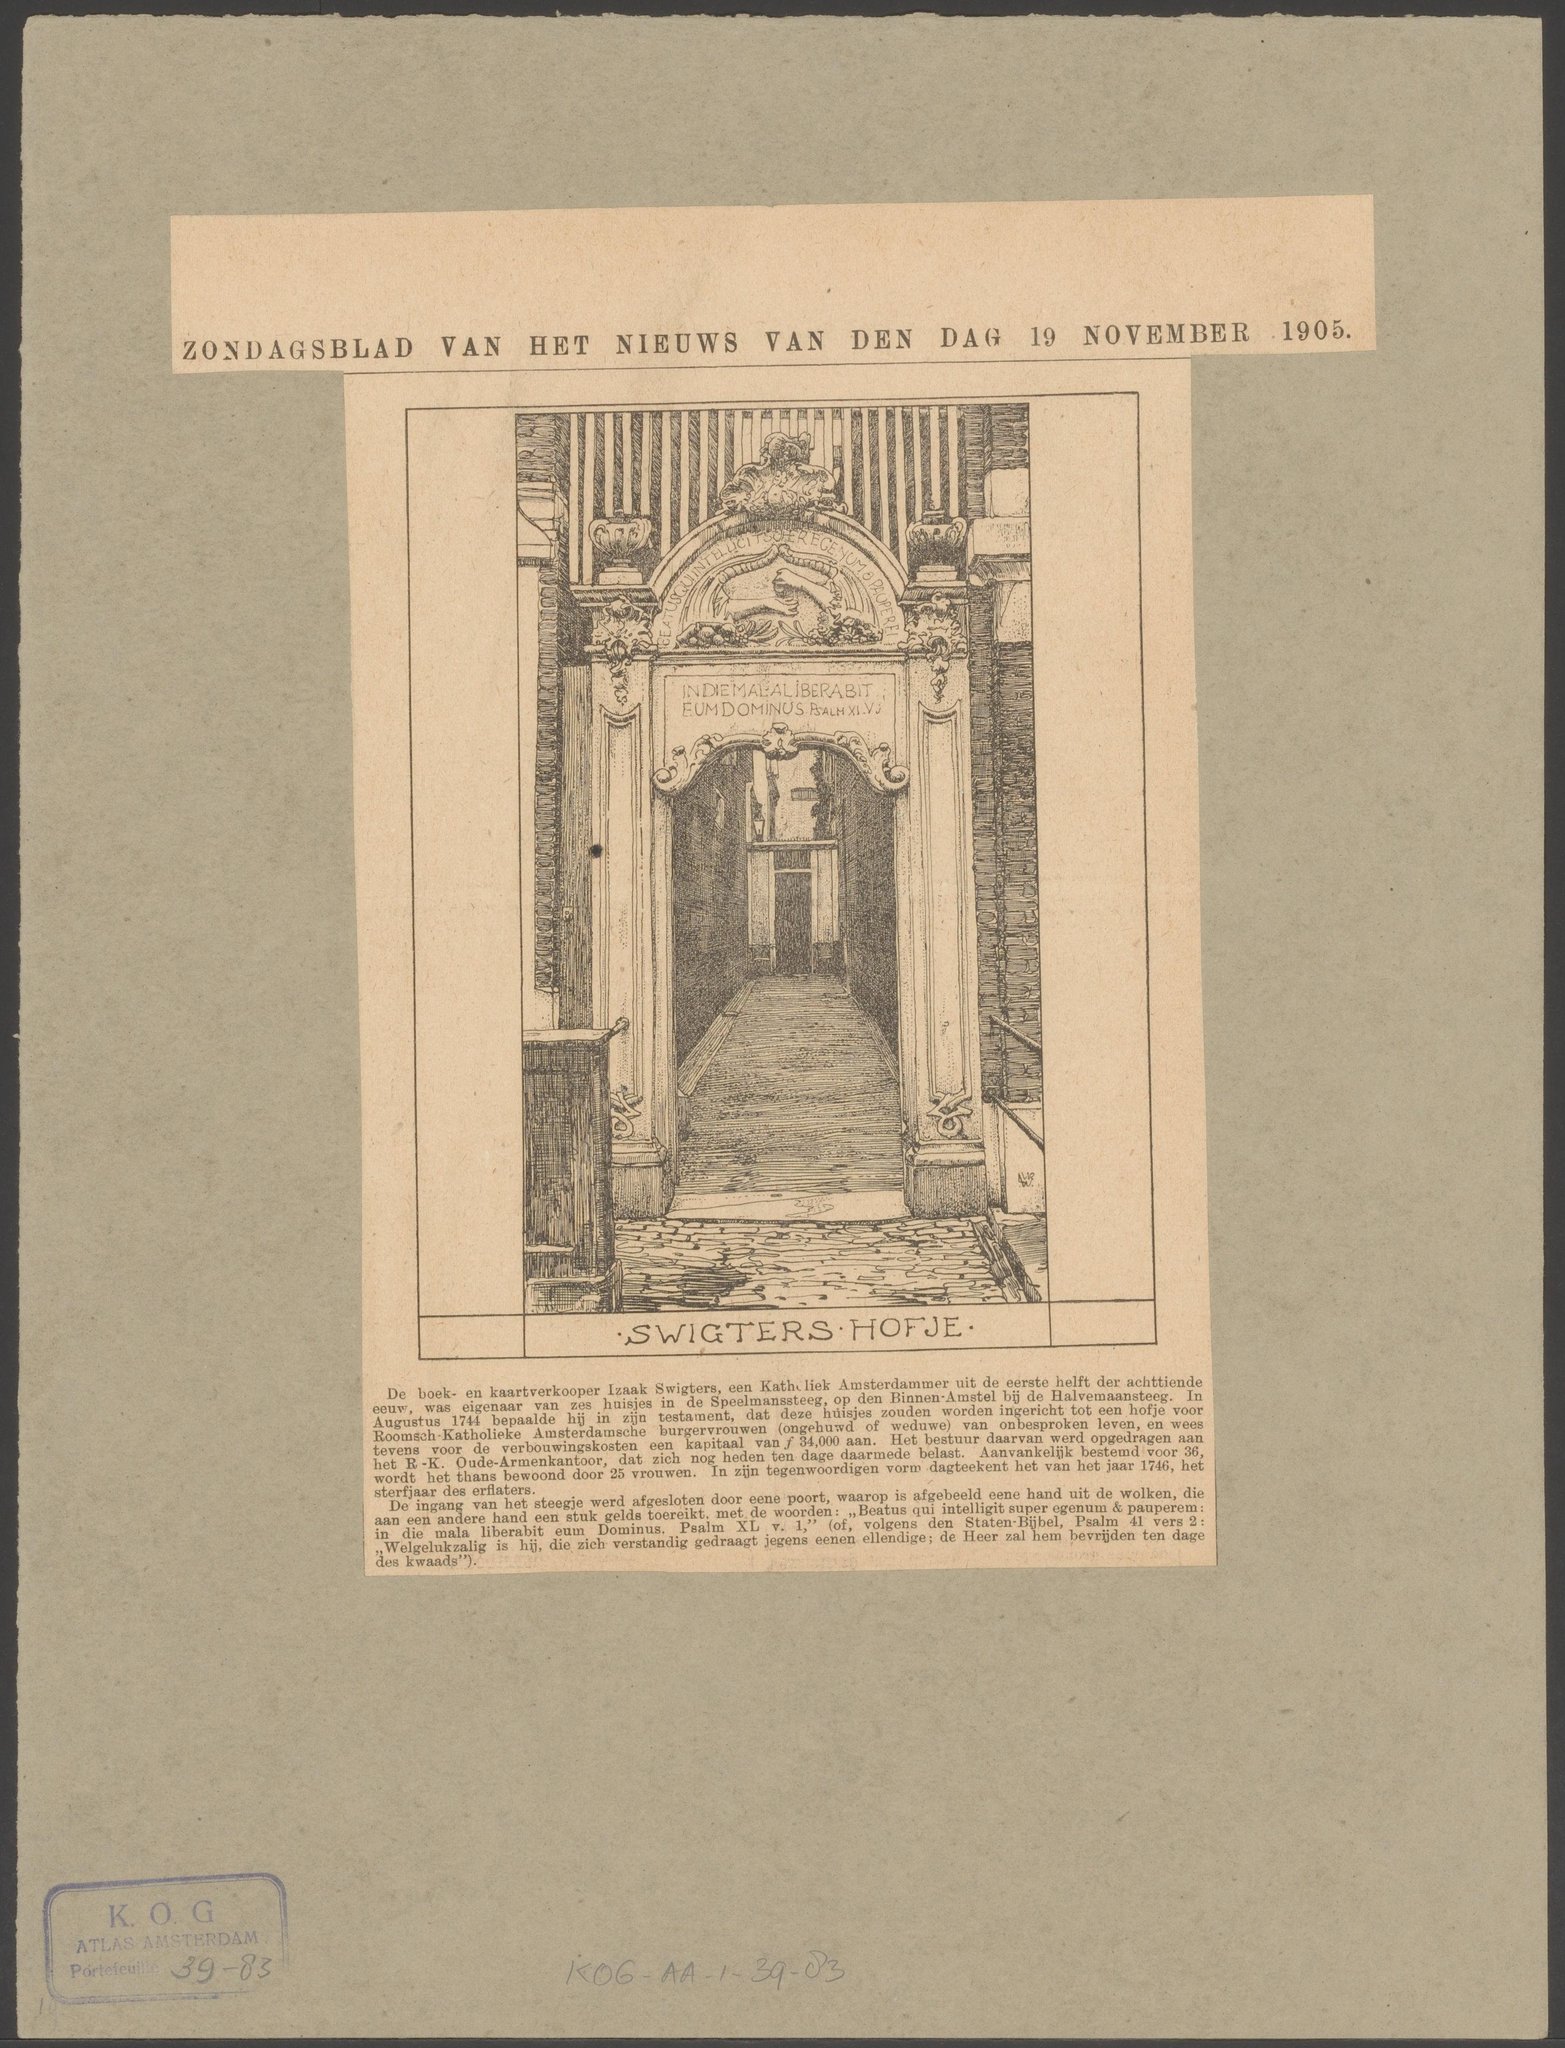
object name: photomechanical print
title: Swigters Hofje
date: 1905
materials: paper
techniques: letterpress printing, line block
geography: netherlands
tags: alms-house (dutch: 'hofje'), gate, entrance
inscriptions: collector's mark: Lugt 1641b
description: Onderwerpsrubriek binnen de Atlas Amsterdam: Armwezen en liefdadige instellingen: III. Verschillende gestichten en instellingen / Hofjes: Spiegelhuisjes - Swigters Hofje - Hofje de Zeven Keurvorsten - Zonshofje.